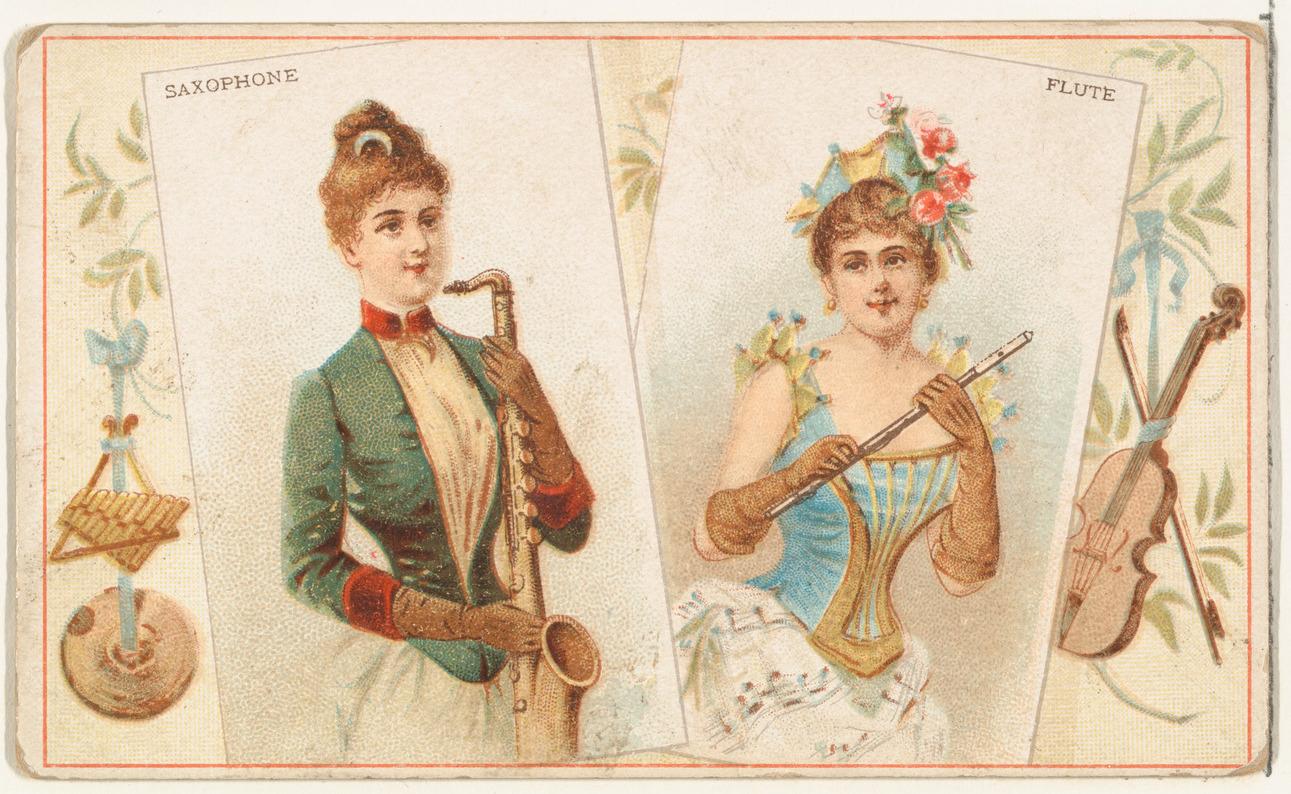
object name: print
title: Saxophone and Flute, from the Musical Instruments series (N121) issued by Duke Sons & Co. to promote Honest Long Cut Tobacco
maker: w. duke, sons & co.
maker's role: publisher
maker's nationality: american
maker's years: 1870-1920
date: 1888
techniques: color lithograph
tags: women,flutes